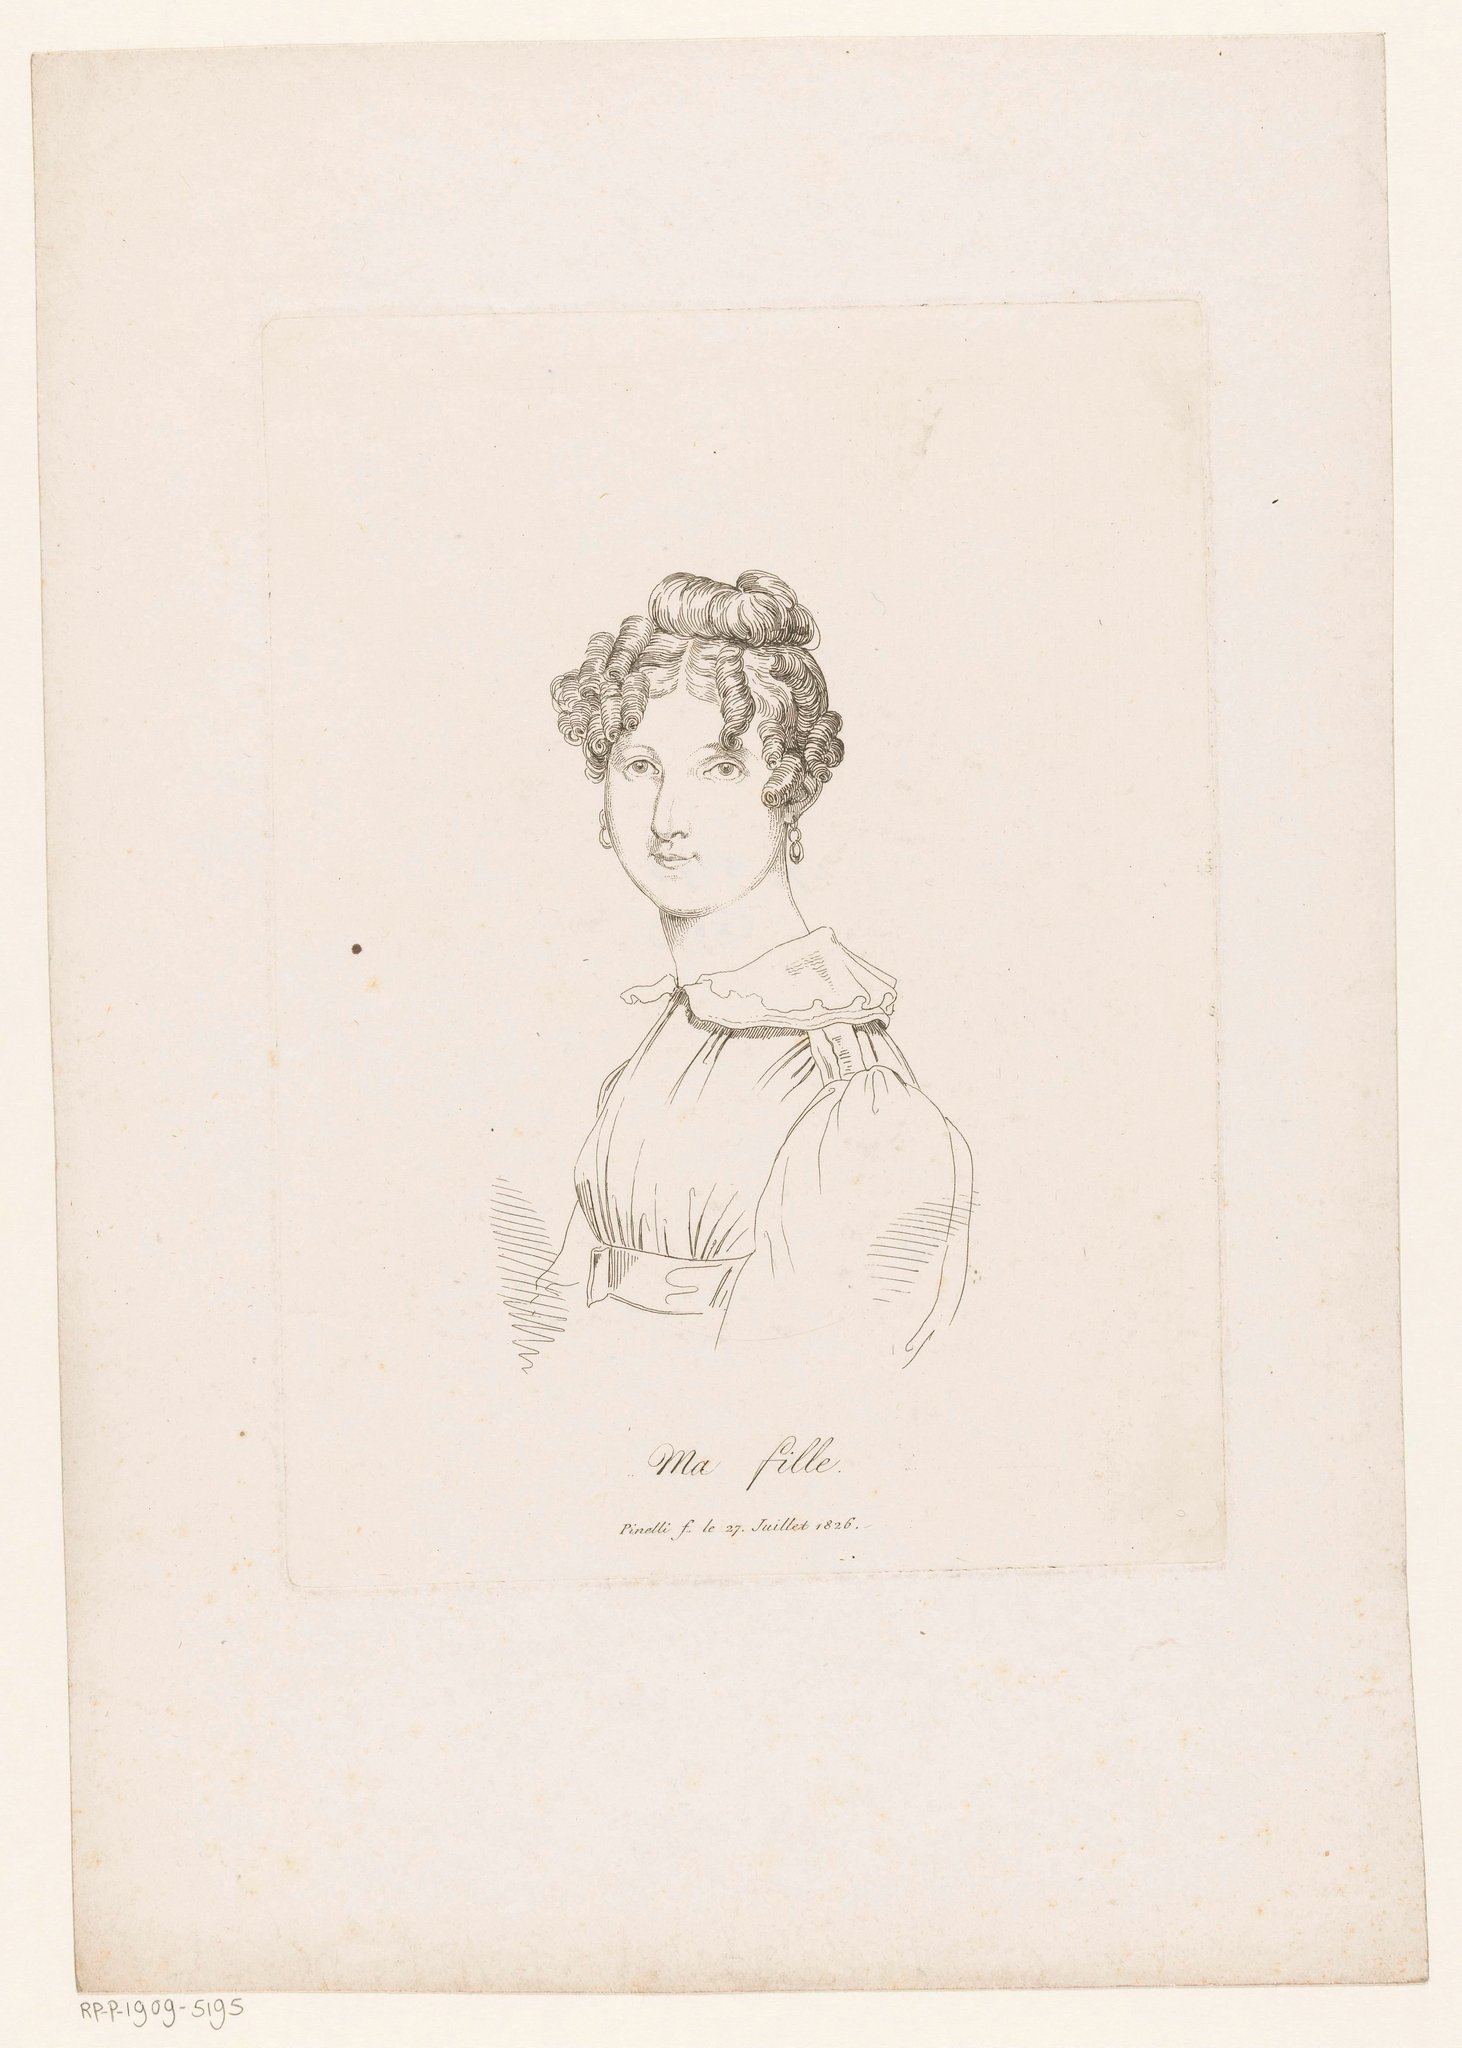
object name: print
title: Portret van de dochter van de kunstenaar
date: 1826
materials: paper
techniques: etching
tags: historical persons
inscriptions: collector's mark: Lugt 2228